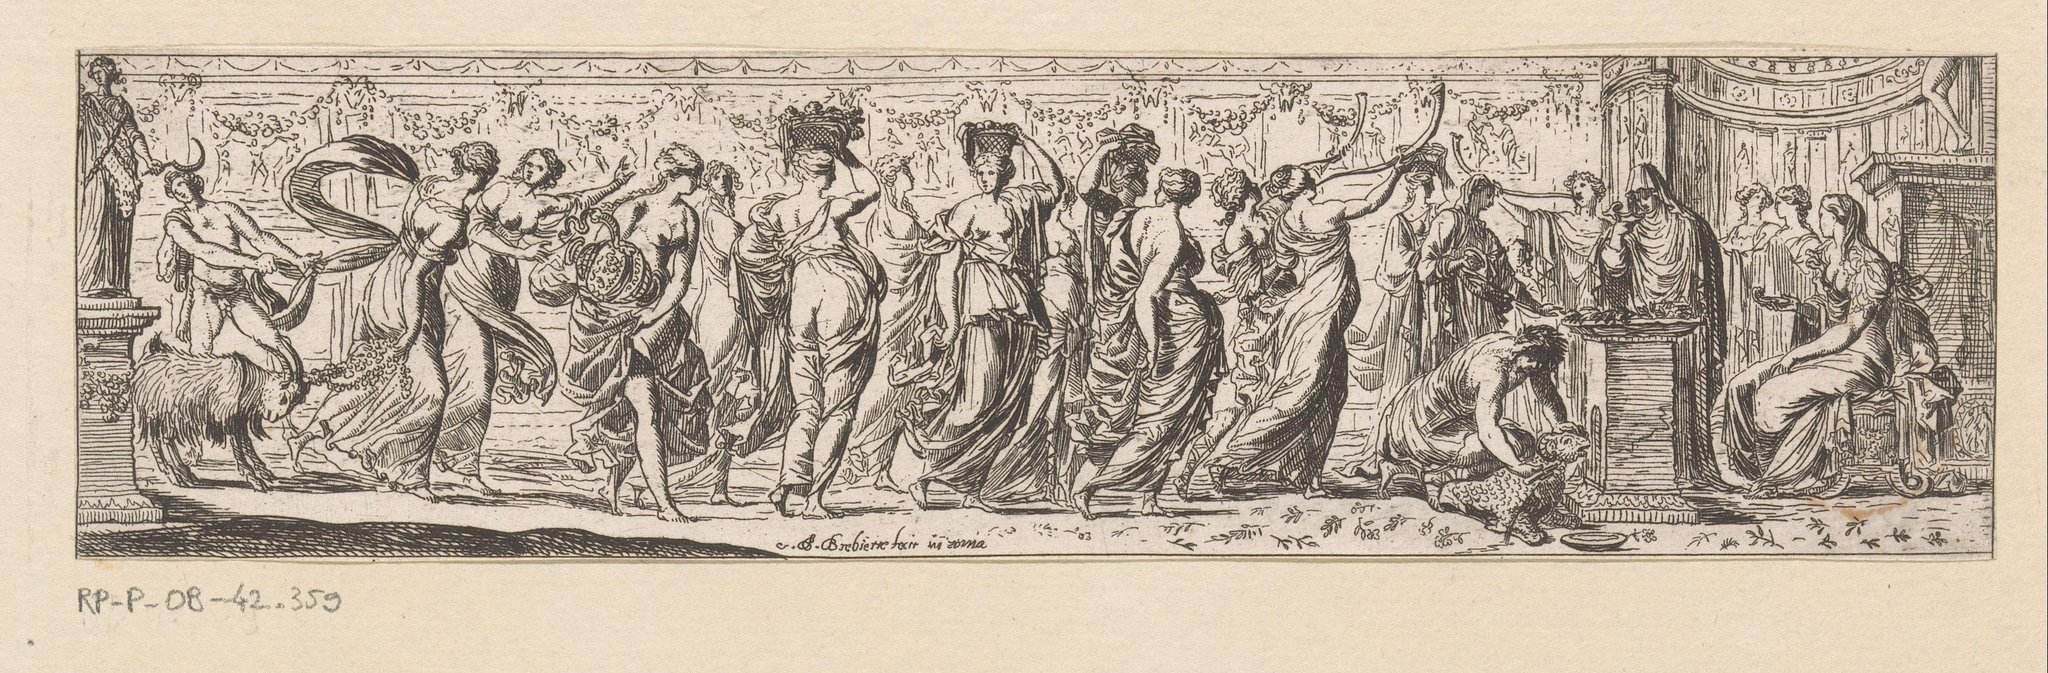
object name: print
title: Offerfeest met rechts een bok die geofferd wordt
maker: pierre brebiette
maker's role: draughtsman, print maker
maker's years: 1598-1650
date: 1617-1626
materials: paper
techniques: etching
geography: rome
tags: sacrificial feast ~ non-christian religions, procession ~ non-christian religions, animal sacrifice ~ non-christian religions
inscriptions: collector's mark: Lugt 240